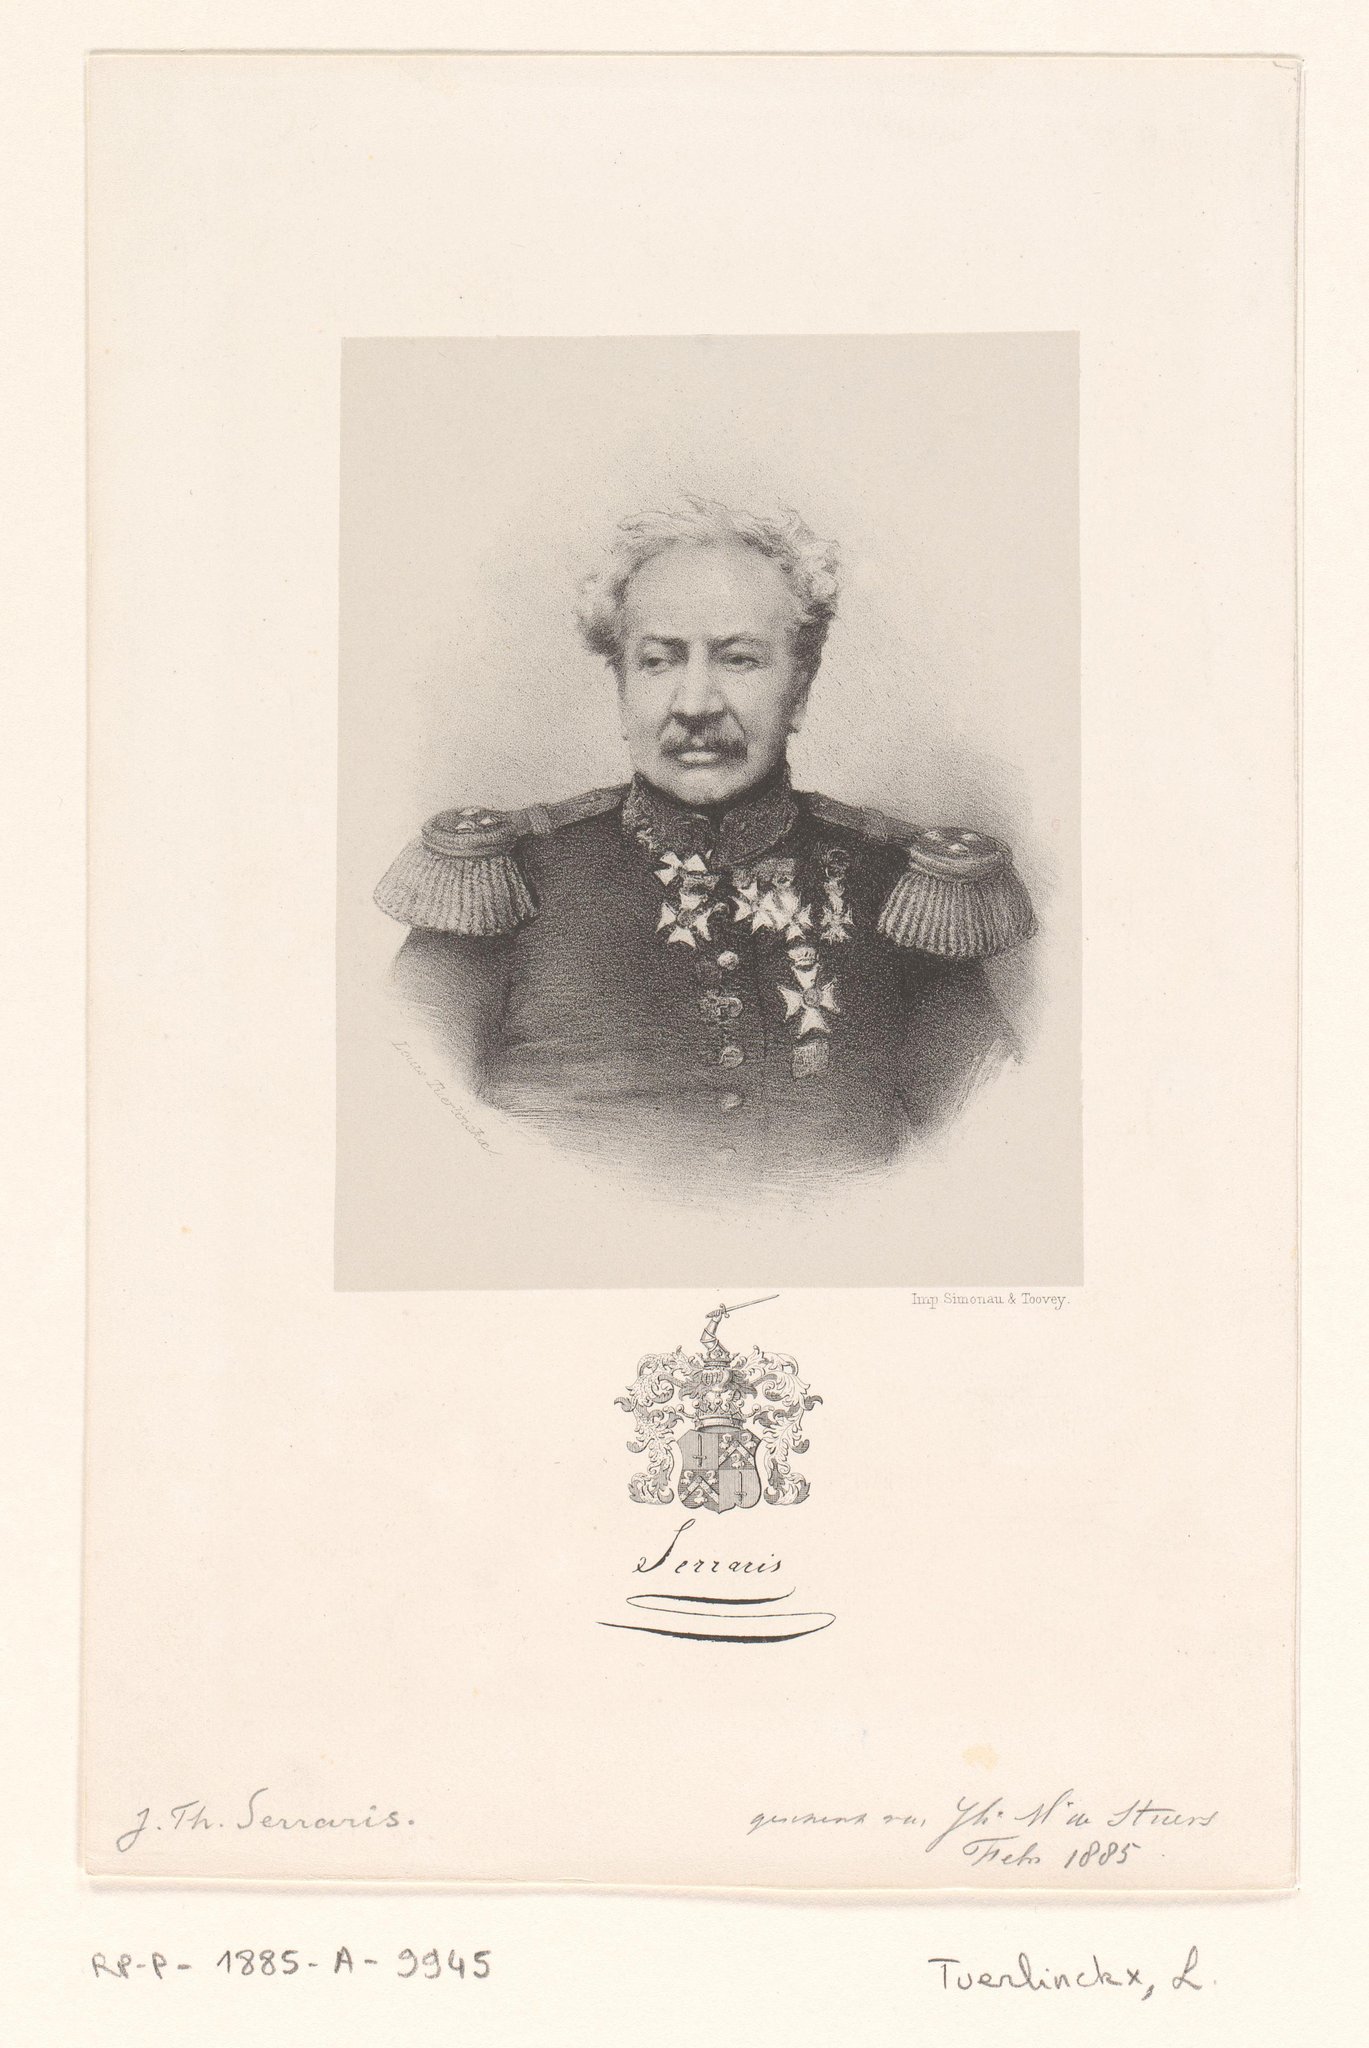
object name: print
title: Portret van Jan Theodoor Serraris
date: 1830-1872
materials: paper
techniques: lithograph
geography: brussels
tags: adult man, historical persons, (military) uniforms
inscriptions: collector's mark: Lugt 2228